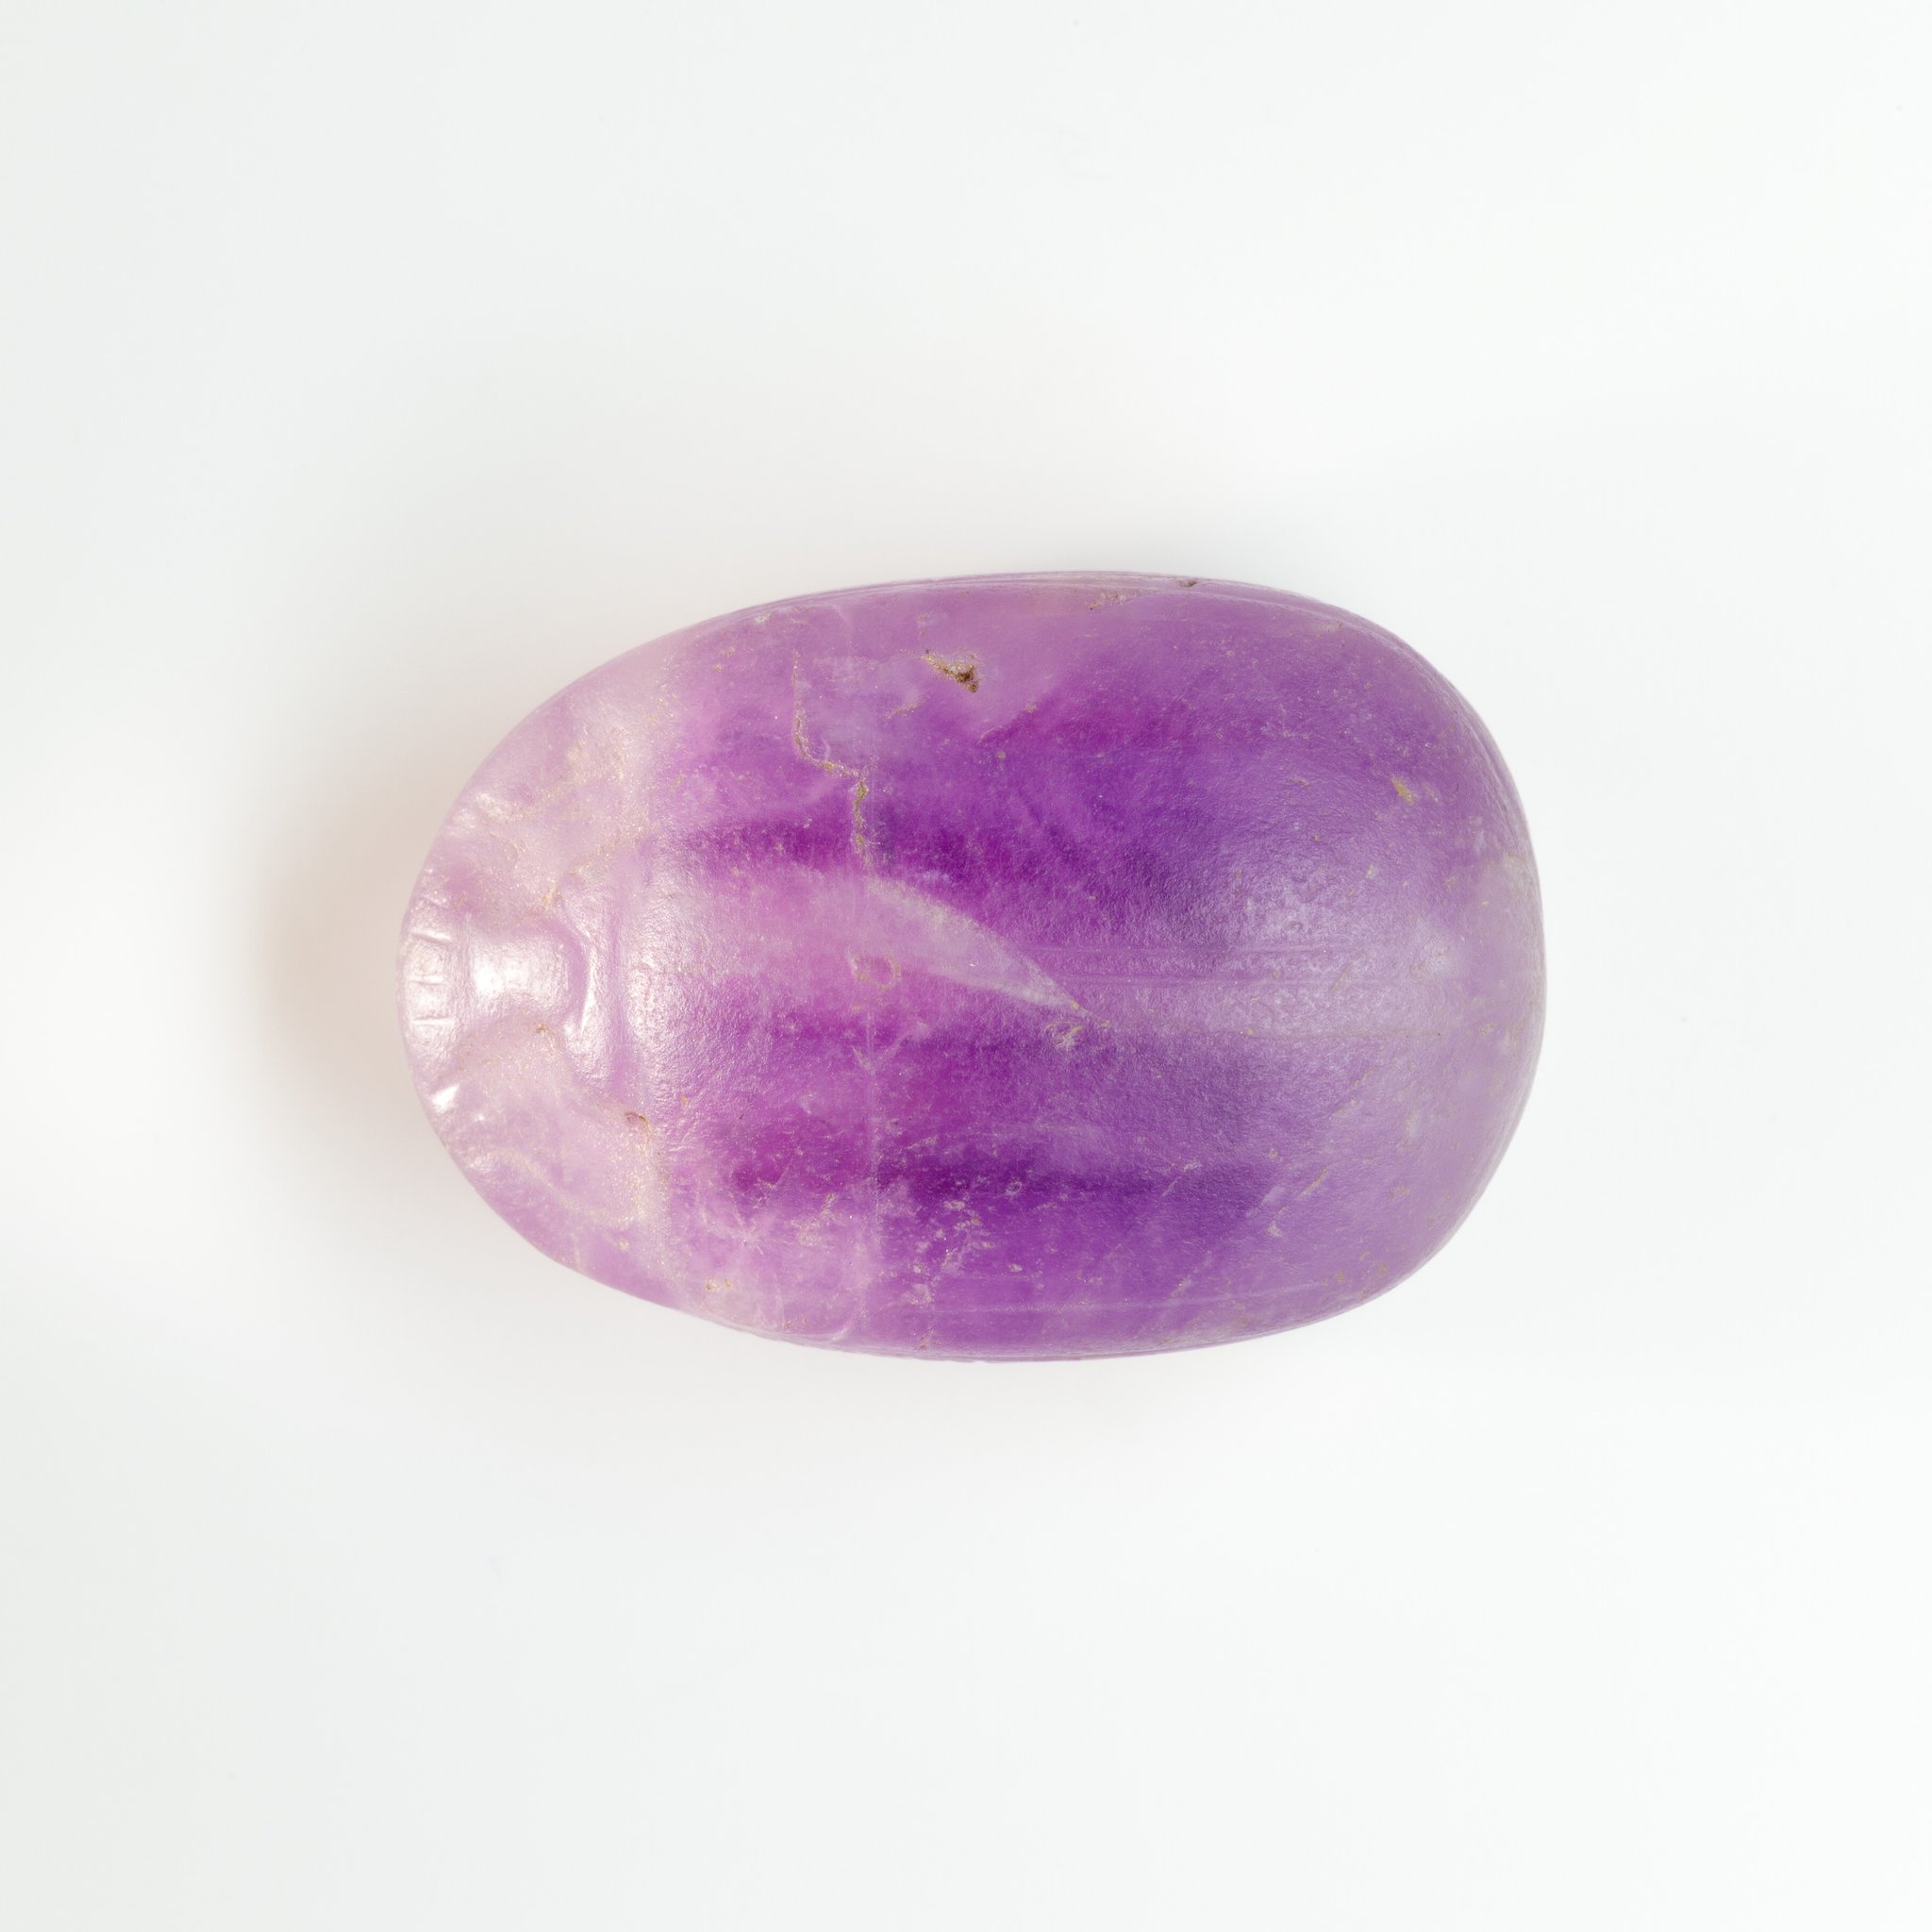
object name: scarab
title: Uninscribed Scarab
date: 1850-1700 BCE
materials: gemstone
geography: egypt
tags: scarabs